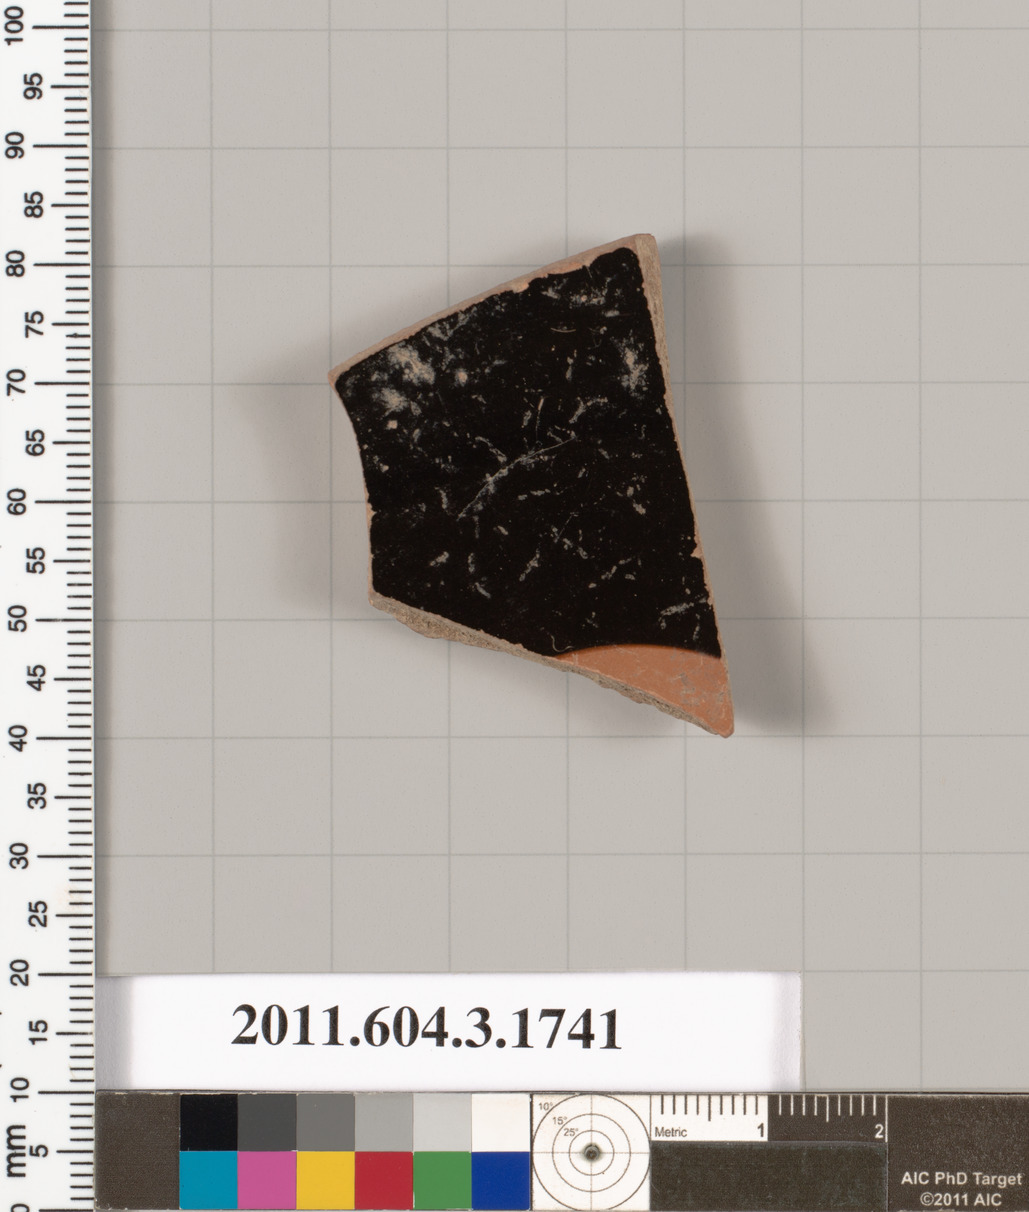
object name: kylix fragment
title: Terracotta fragment of a kylix: Band or lip cup (drinking cup)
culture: greek, attic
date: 550-526 BCE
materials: terracotta